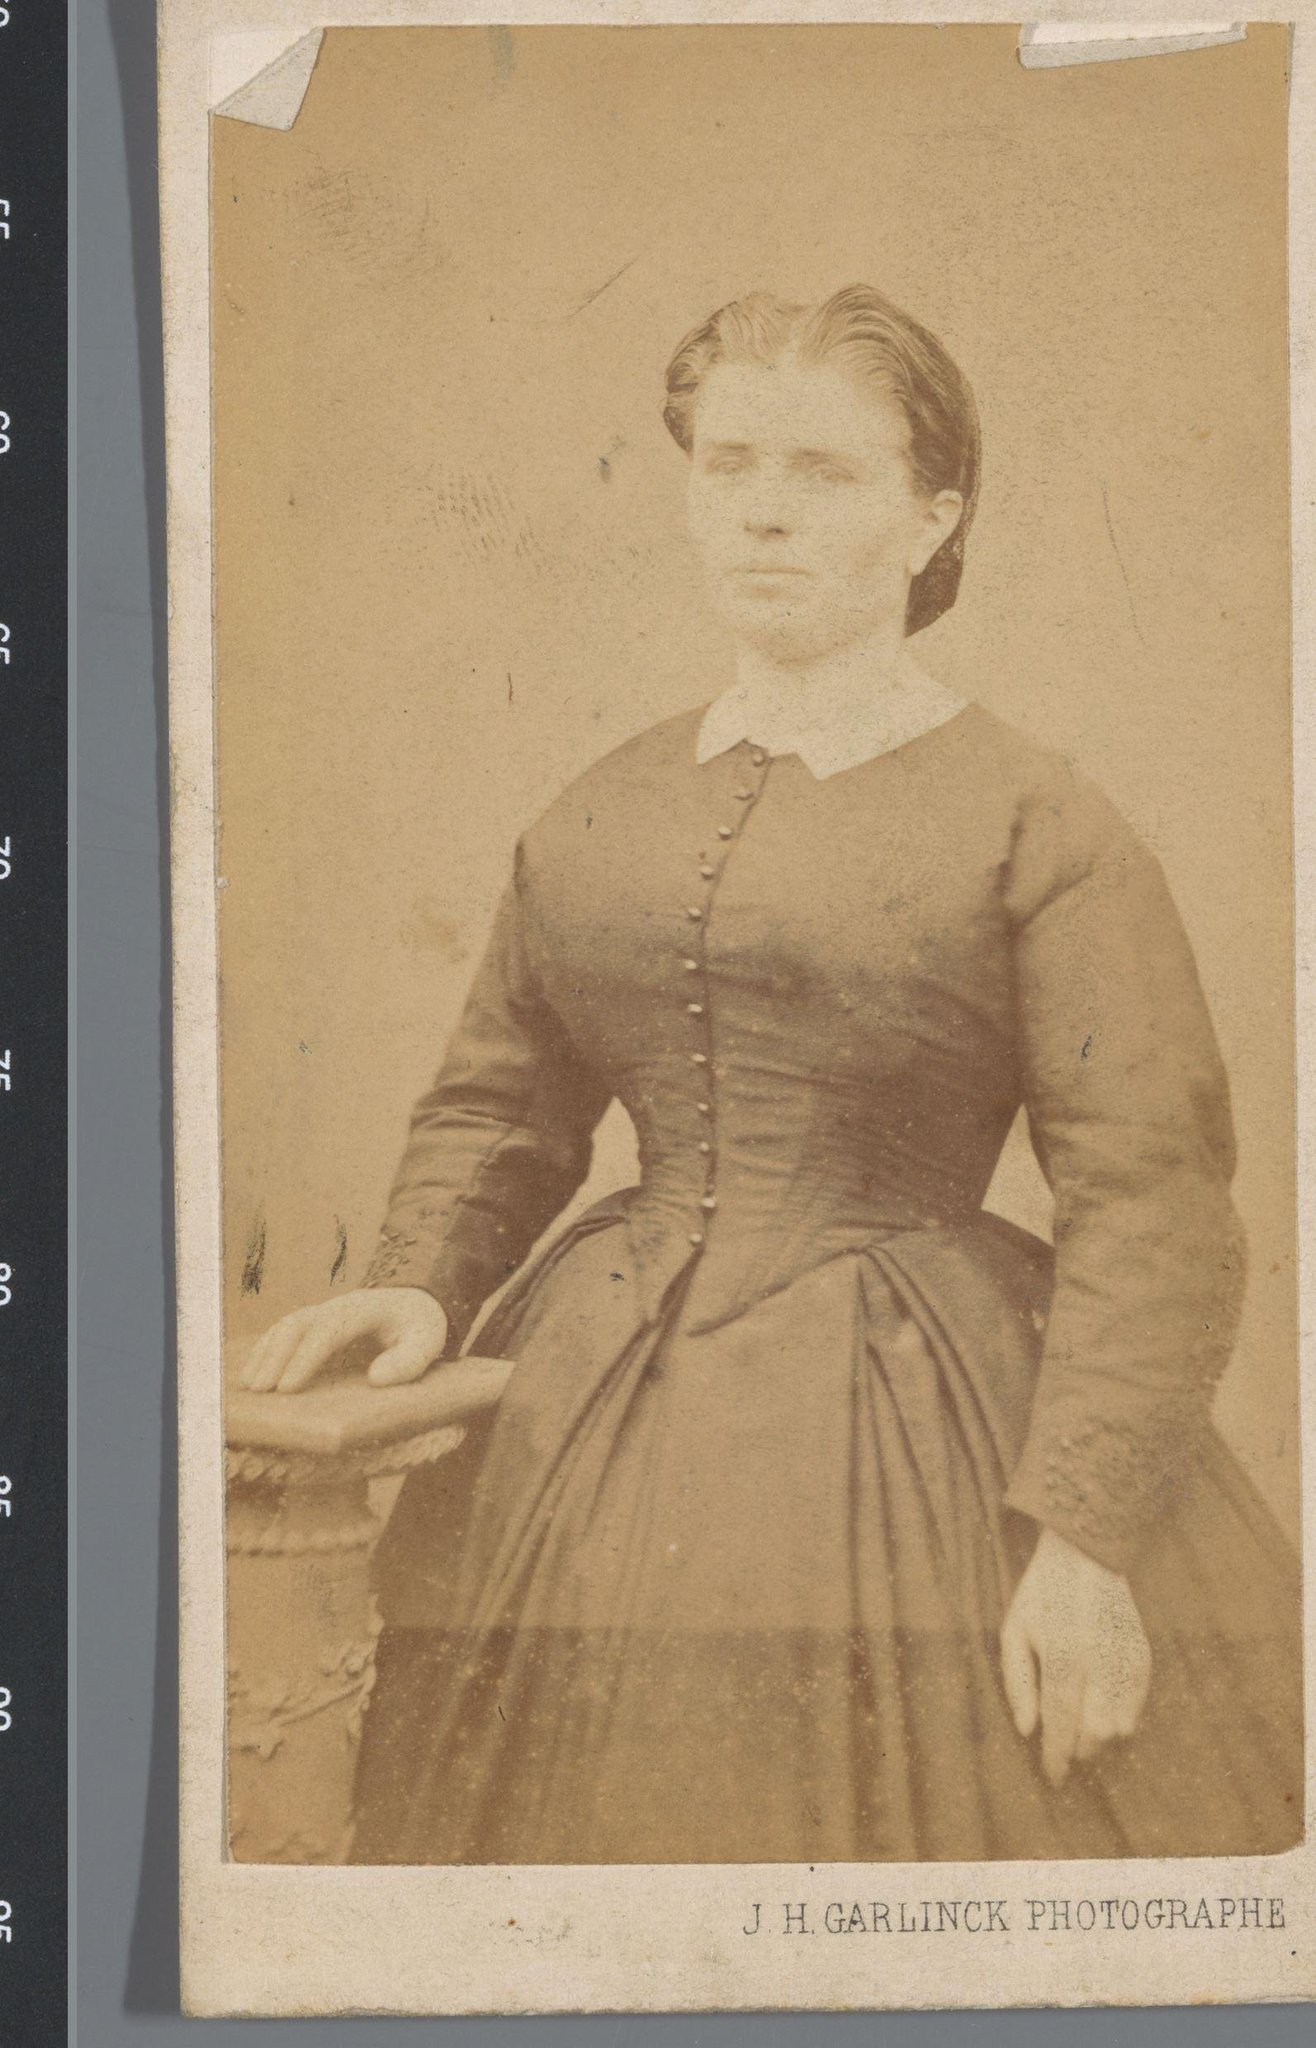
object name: photograph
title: Portret van een onbekende vrouw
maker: jan hendrik garlinck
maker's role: fotograaf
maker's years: 1833-1887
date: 1863-1880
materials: cardboard, paper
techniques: albumen print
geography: antwerp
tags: adult woman, anonymous historical person portrayed, antwerp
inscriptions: inscription: ‘Établissement photographique/ J.H. Garlinck/ photographe, doreur, miroitier/ et encadreur/ Longue rue Porte auxVaches/ No. 21/ Anvers.’, inscription: ‘J.H. Garlinck Photographe’